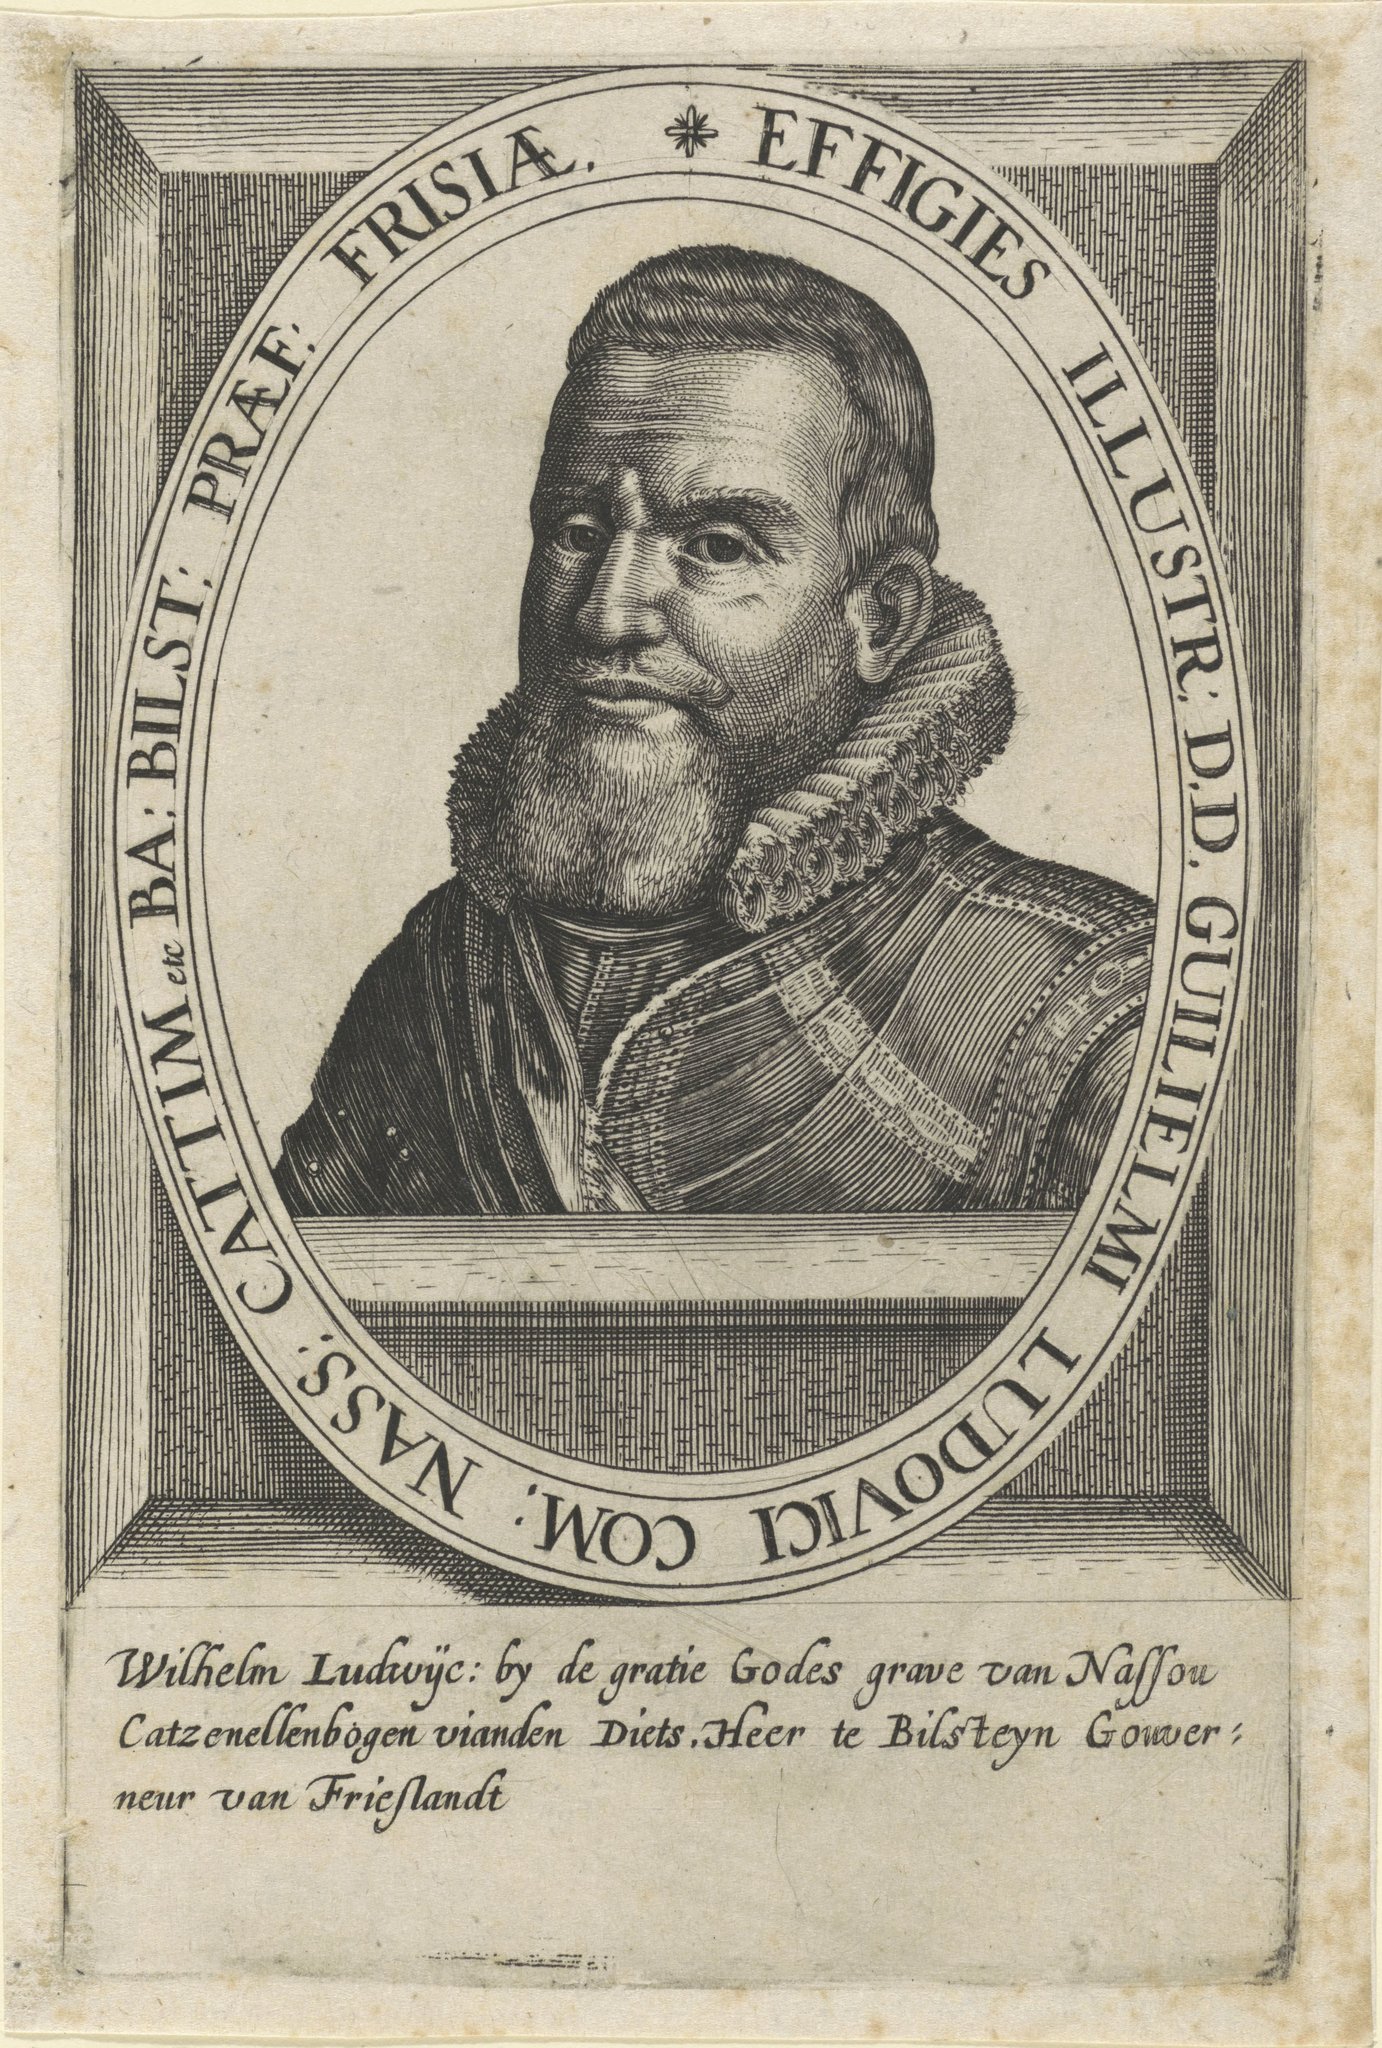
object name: print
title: Portret van Willem Lodewijk, graaf van Nassau-Dillenburg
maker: Anonymous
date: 1600-1699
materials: paper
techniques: engraving, etching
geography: low countries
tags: willem lodewijk graaf van nassau-dillenburg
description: De hier vermelde titel verwijst naar de hoogst verkregen titel van de geportretteerde, niet per se naar de titel die de geportretteerde op deze voorstelling draagt.